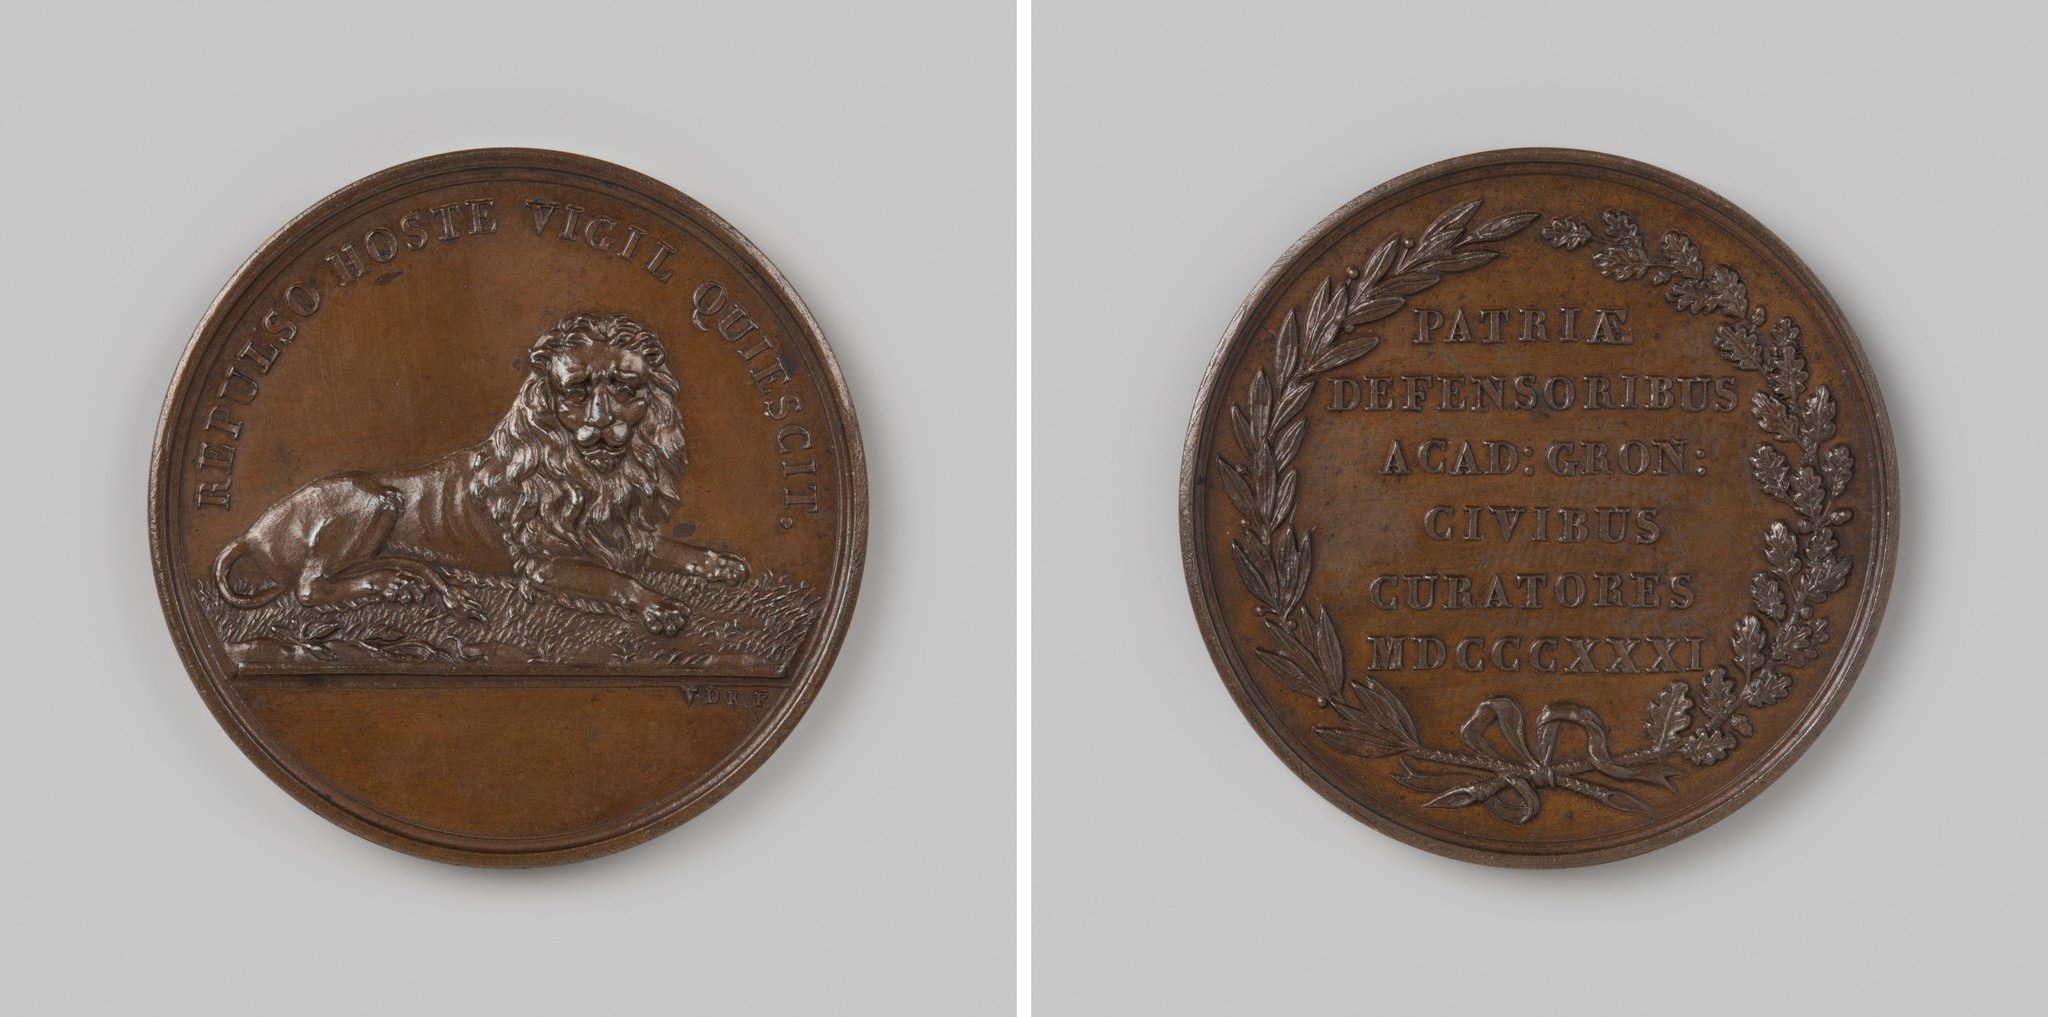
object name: honorary medal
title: Curatoren der Groningse hogeschool, penning uitgereikt aan de uitgetrokken studenten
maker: david van der kellen (1804-1879)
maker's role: die cutter, draughtsman, print maker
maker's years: 1804-1879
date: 1831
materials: bronze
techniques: striking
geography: utrecht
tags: rijksuniversiteit groningen, groningen, belgische revolutie, tiendaagse veldtocht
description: Bronzen penning. Voorzijde: liggende leeuw binnen omschrift; afsnede: signatuur. Keerzijde: opschrift in tot krans samengebonden eiken- en lauwertak.